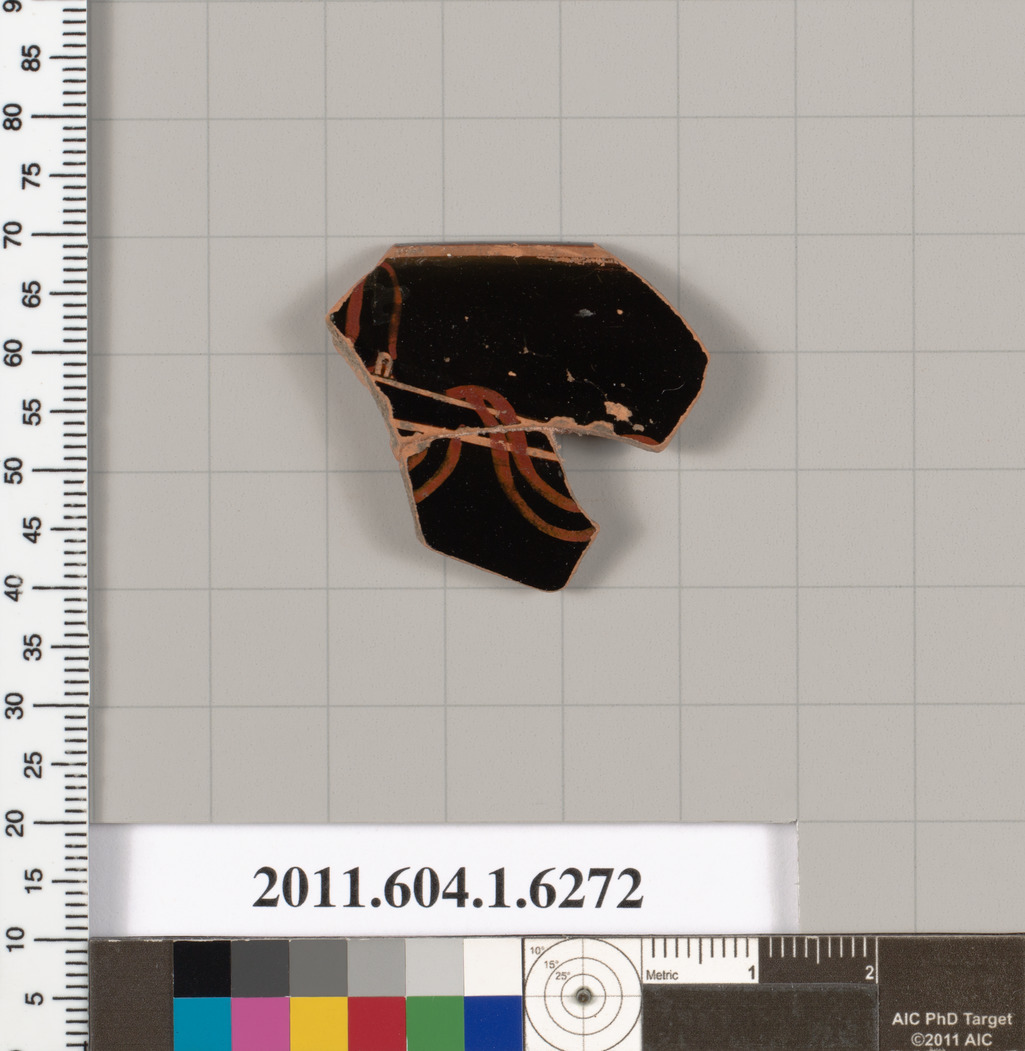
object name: kylix fragment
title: Terracotta rim fragment of a kylix (drinking cup)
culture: greek, attic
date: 500-480 BCE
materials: terracotta